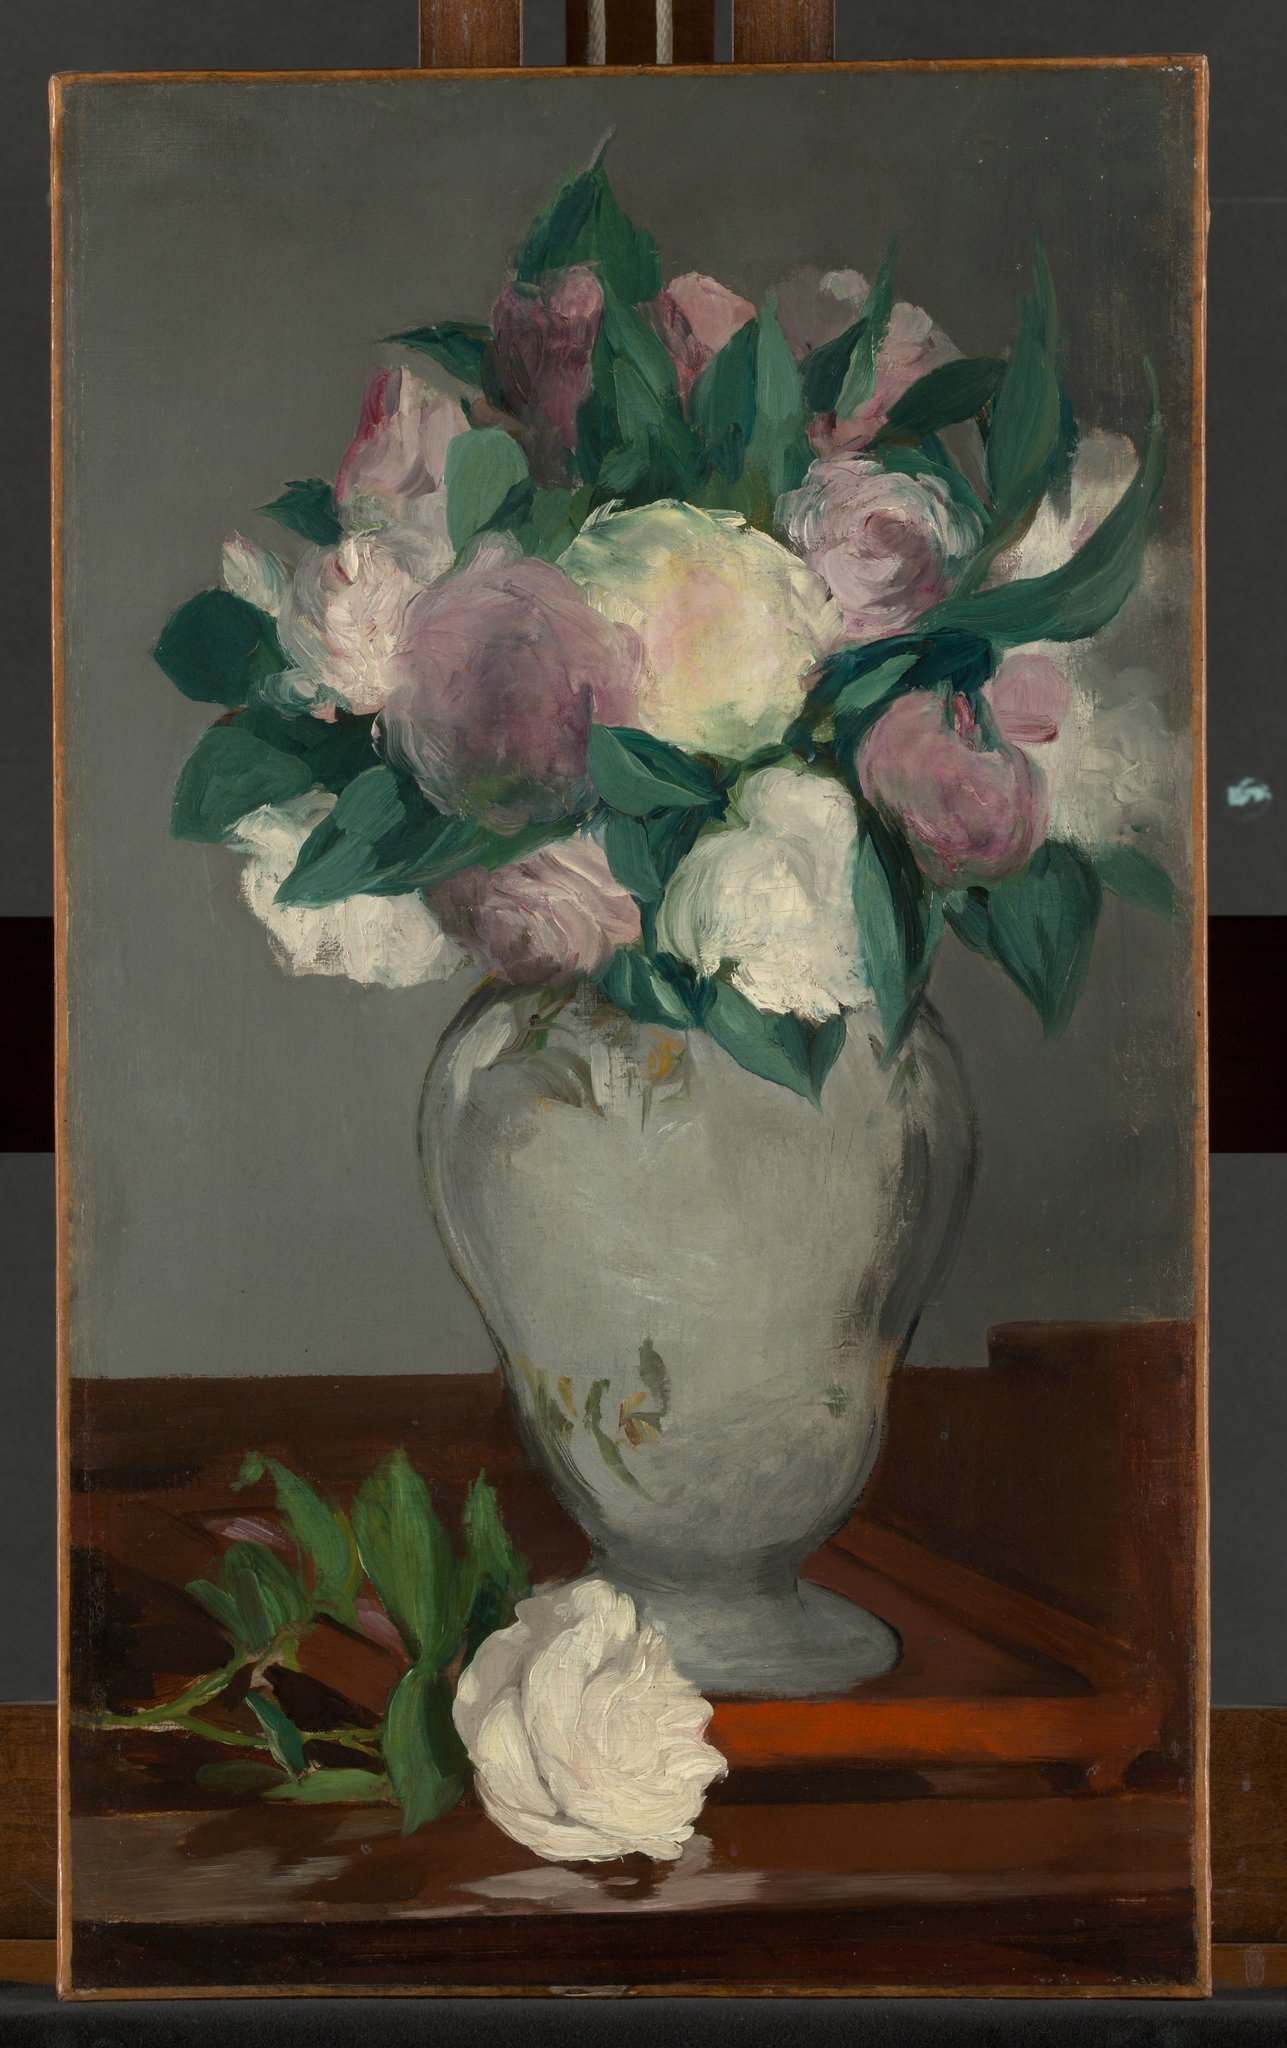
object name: painting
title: Peonies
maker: édouard manet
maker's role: artist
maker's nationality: french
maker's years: 1832-1883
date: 1864-1865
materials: canvas, oil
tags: peonies,still life,vases